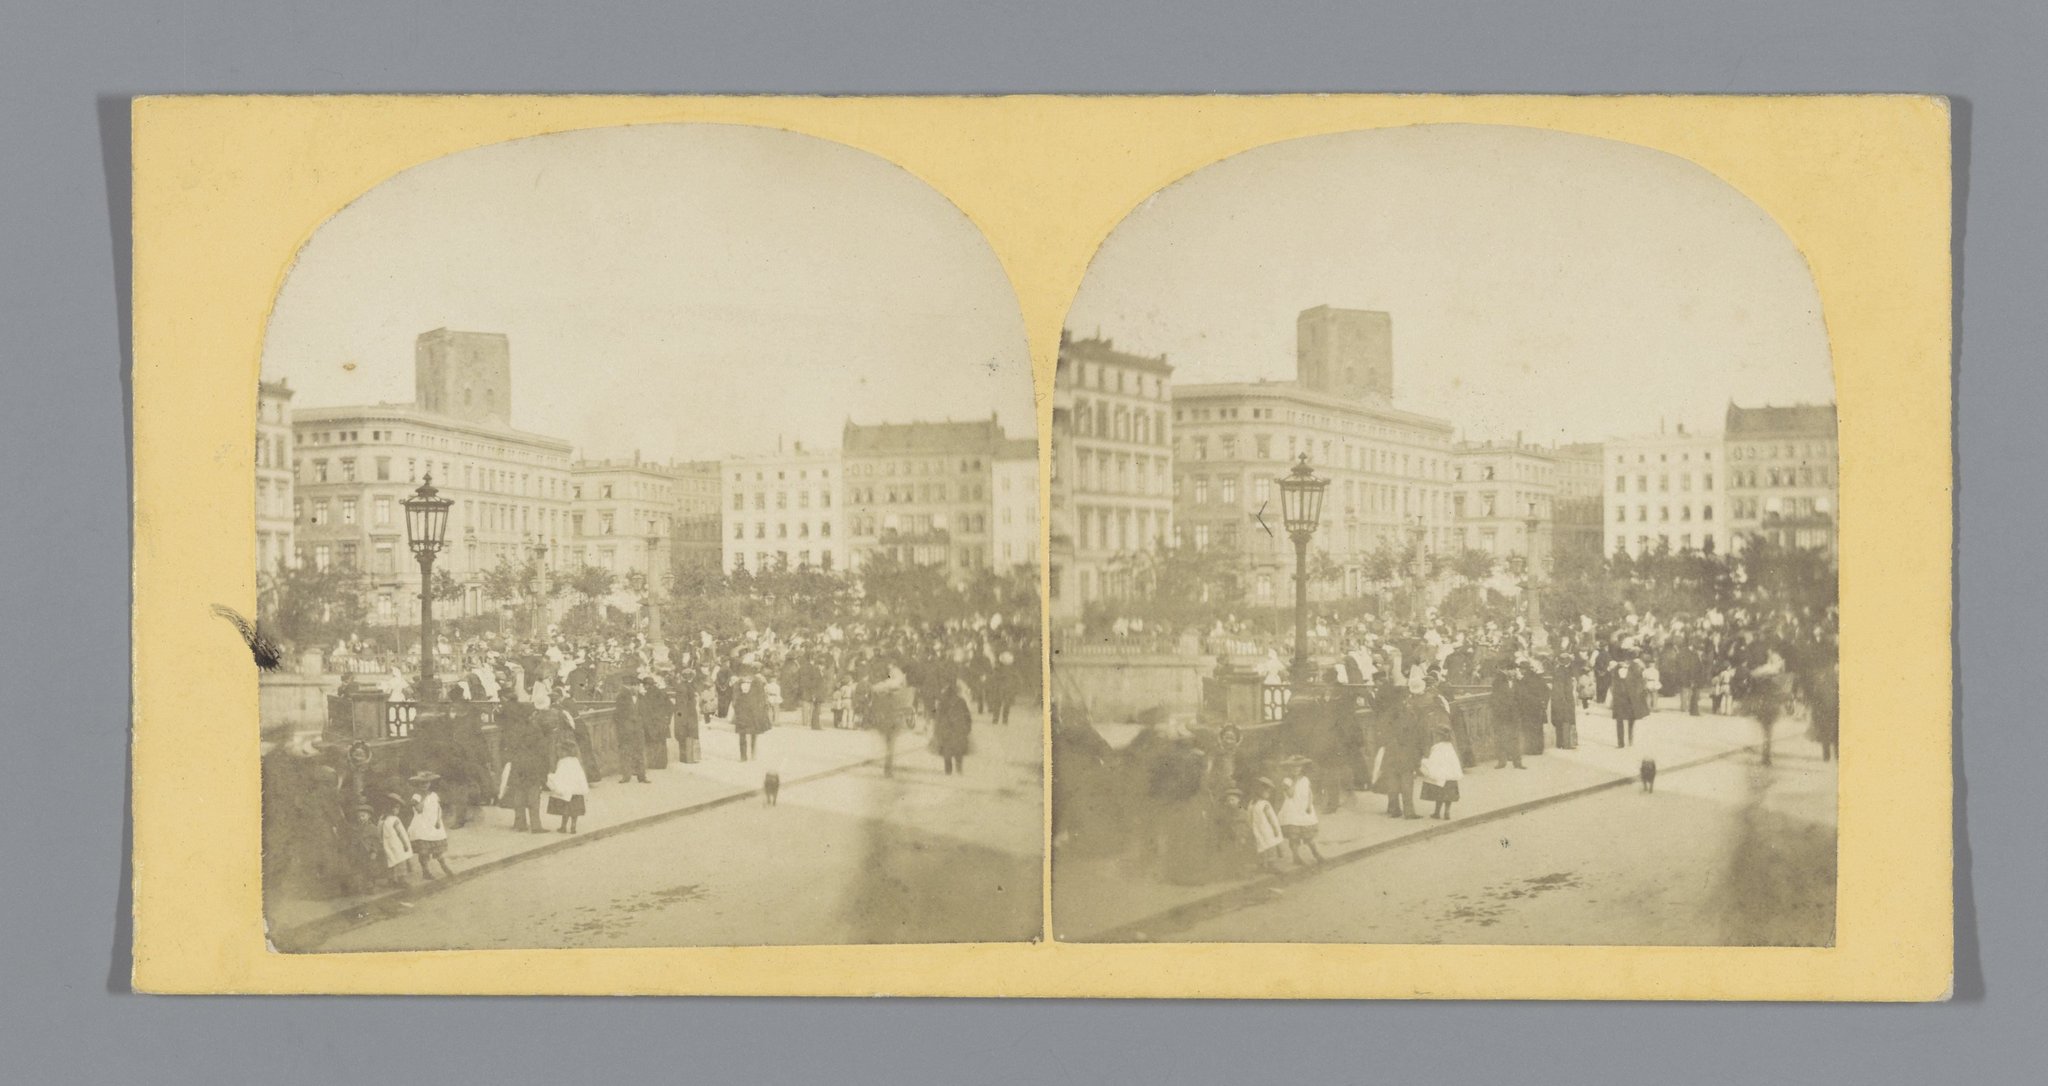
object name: stereograph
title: Rathausmarkt te Hamburg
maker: Anonymous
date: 1860-1880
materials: cardboard, photographic support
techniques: albumen print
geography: rathausmarkt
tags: square, place, circus, etc., façade (of house or building)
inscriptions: inscription: ‘Rathhausmarkt’